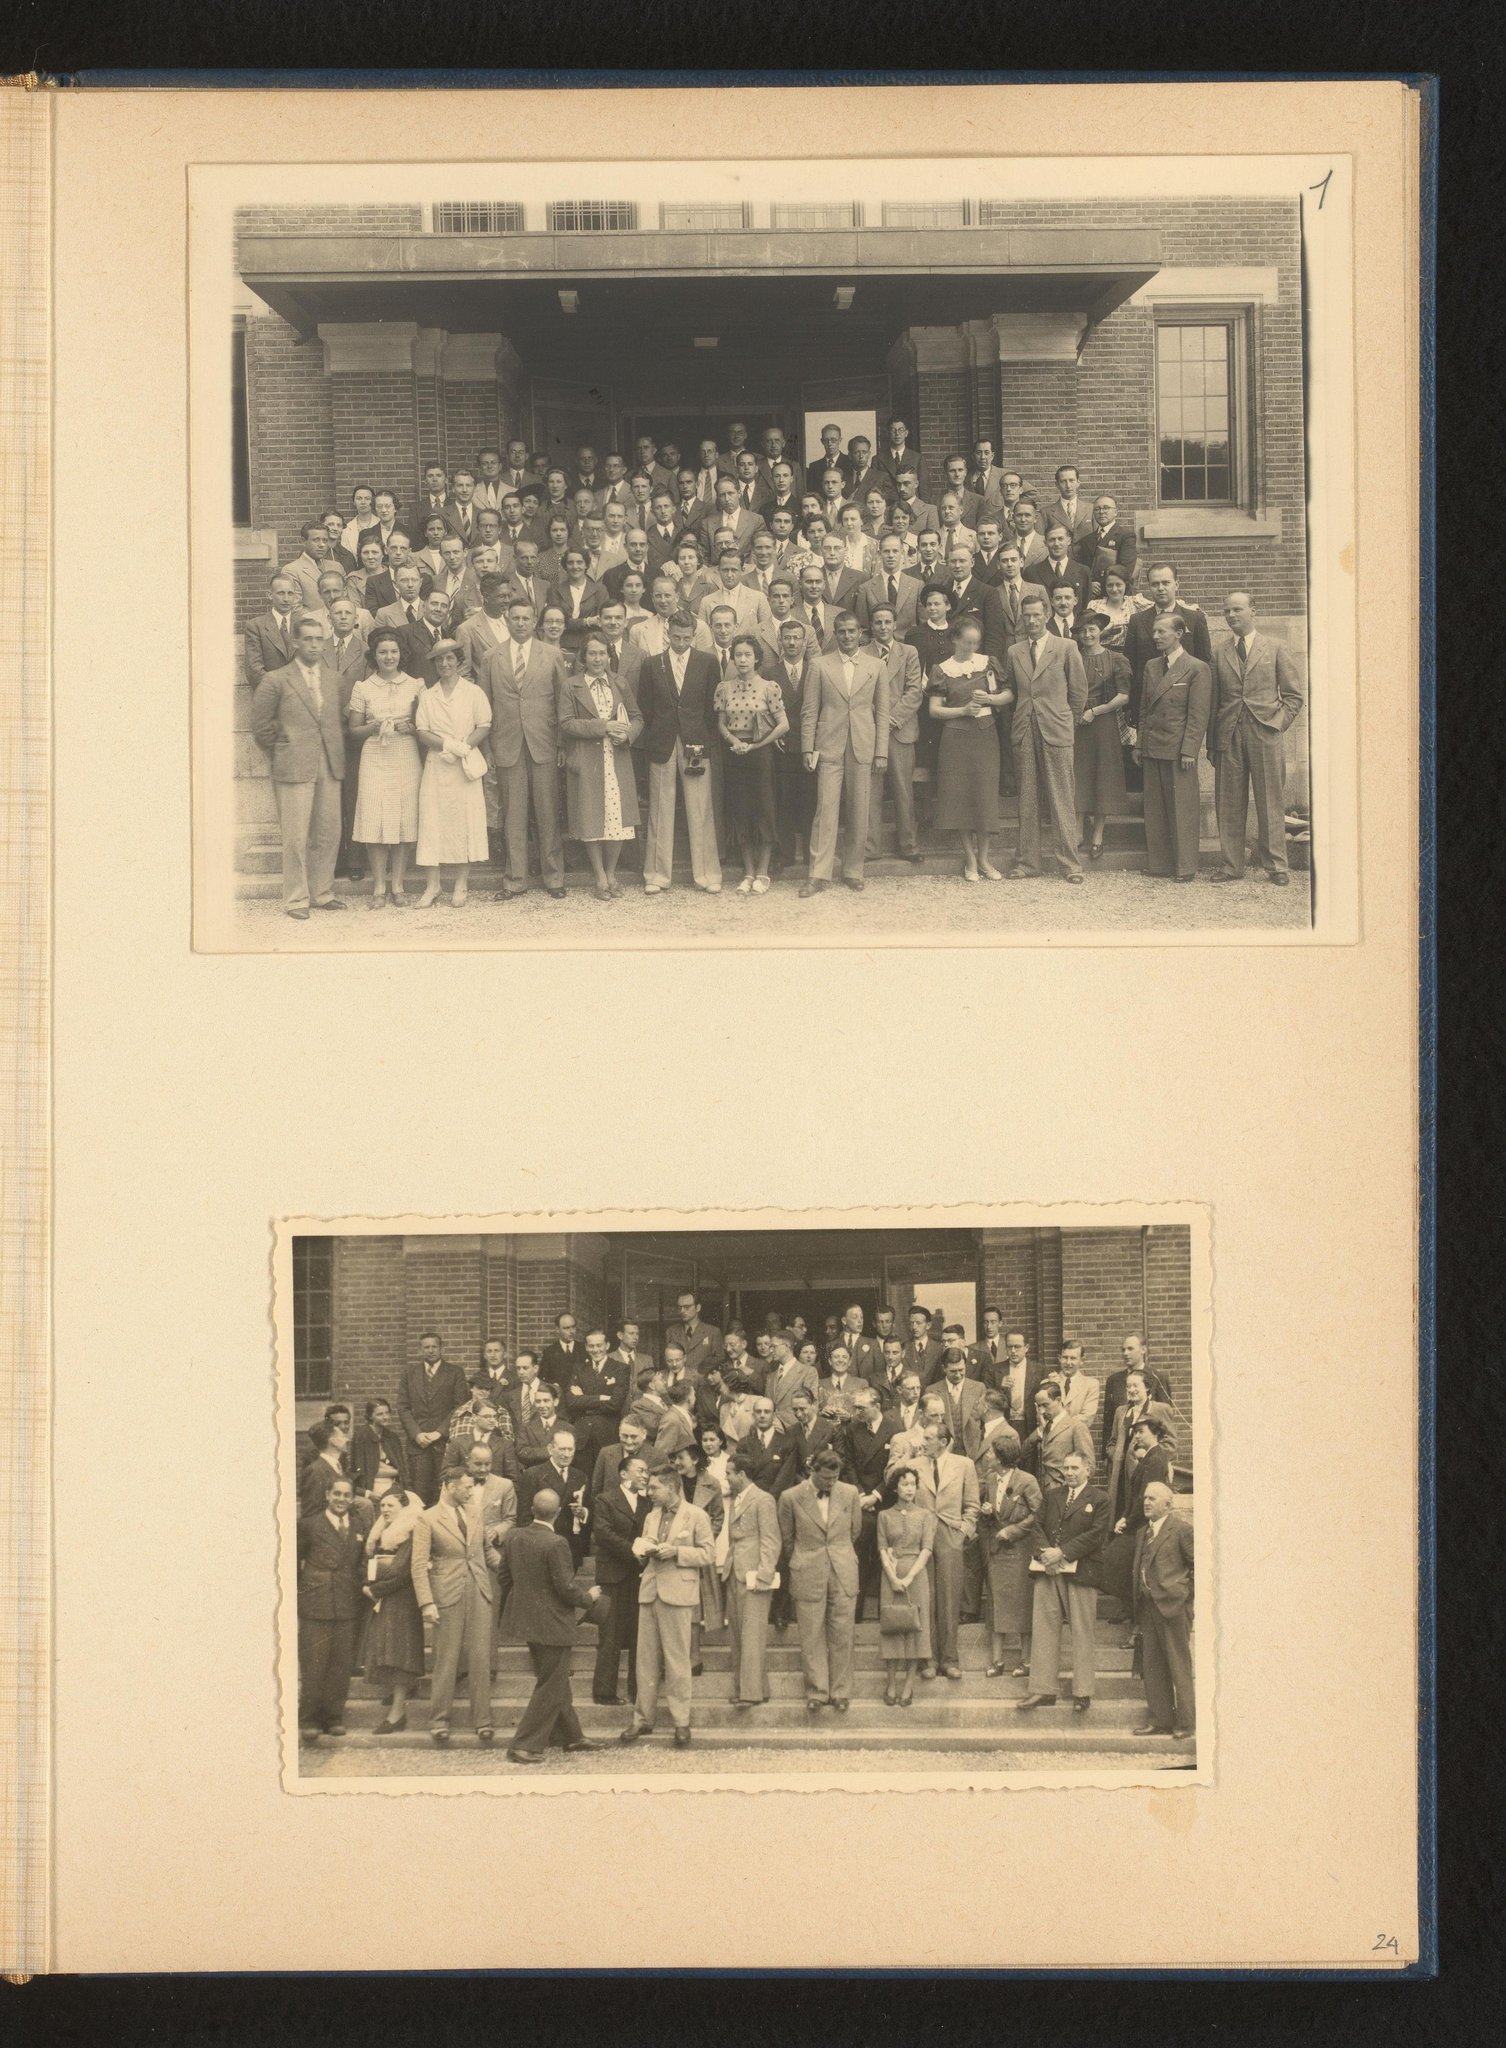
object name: photograph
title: Groepsfoto's met Eef Dumas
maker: Anonymous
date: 1935-1940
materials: cardboard, photographic support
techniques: gelatin silver print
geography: netherlands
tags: surabaya, paris, beatrice jacqueline eveline dumas, historical persons - bb - woman, anonymous historical persons portrayed in a group, in a group-portrait, netherlands, dutch east indies, the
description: Blad met twee foto's van een grote groep (studenten en docenten?) staande op de trappen voor de ingang van een gebouw. Eef Dumas staat (met partner?) in beide foto's op de eerste rij. Onderdeel van het fotoalbum van Beatrice Jacqueline Eveline (Eef) Dumas, ca. 1880-1952.